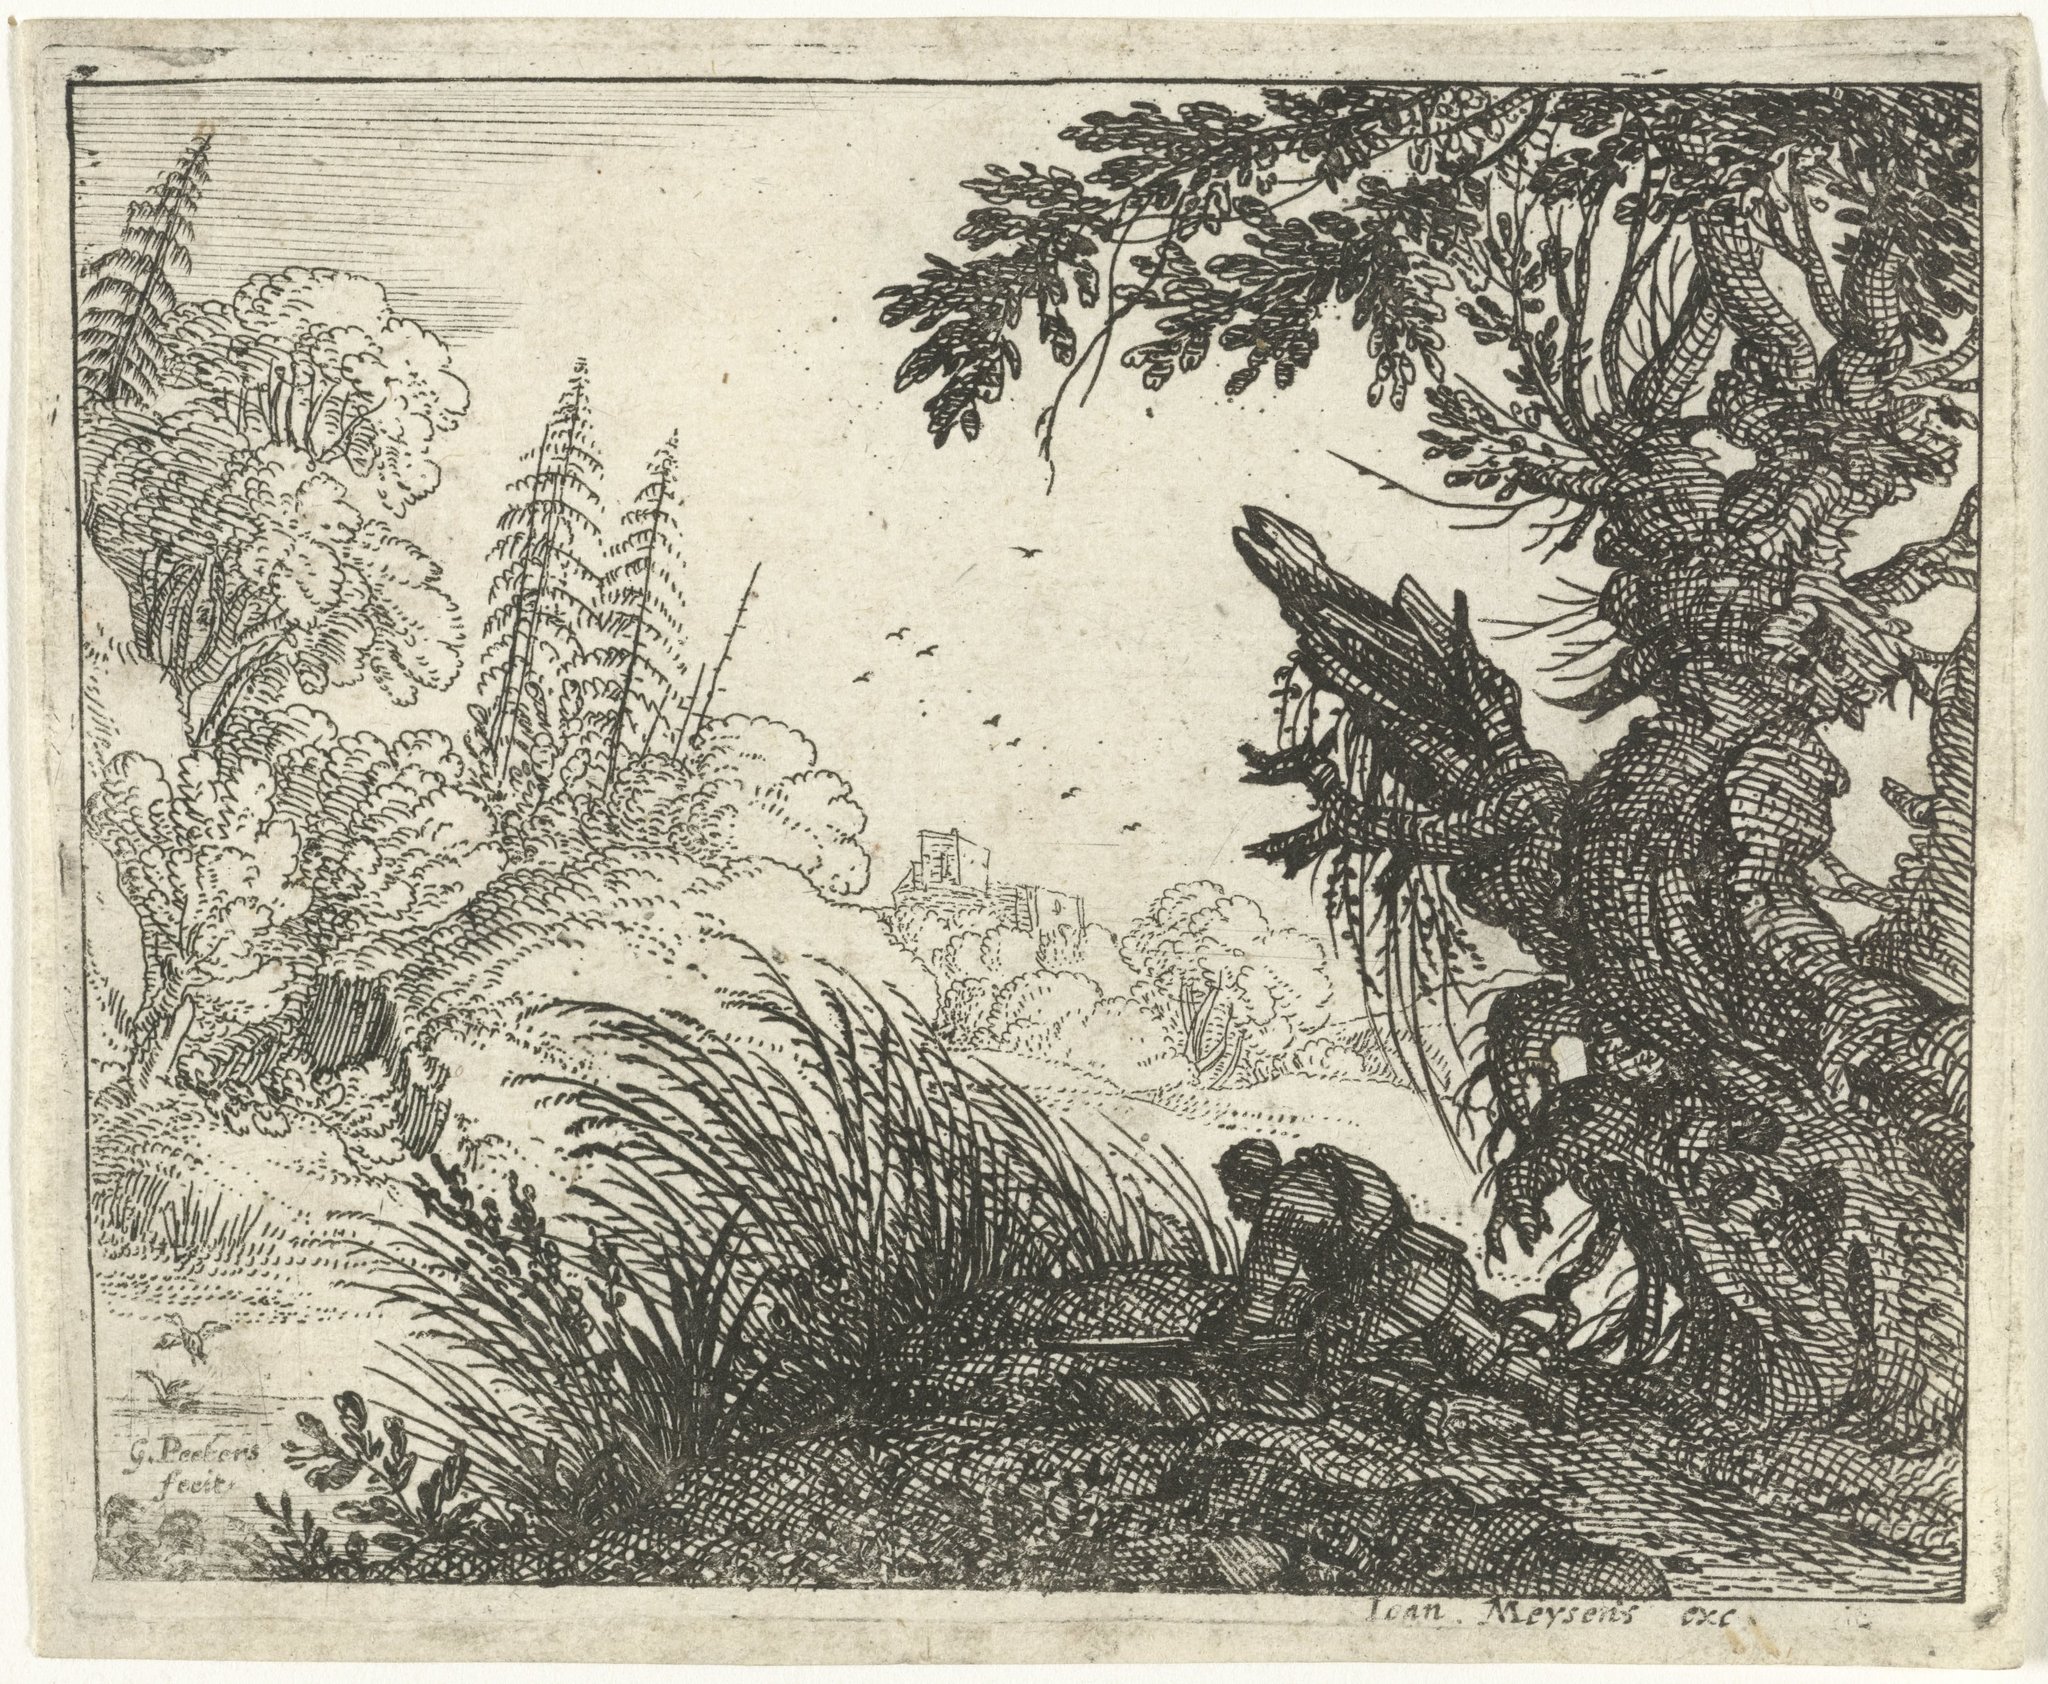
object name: print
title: Landschap met een jager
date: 1622-1653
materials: paper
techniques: etching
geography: antwerp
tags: hunter, bird hunting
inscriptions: collector's mark: Lugt 2228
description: Bosrijk landschap met een jager die op een eend schiet.